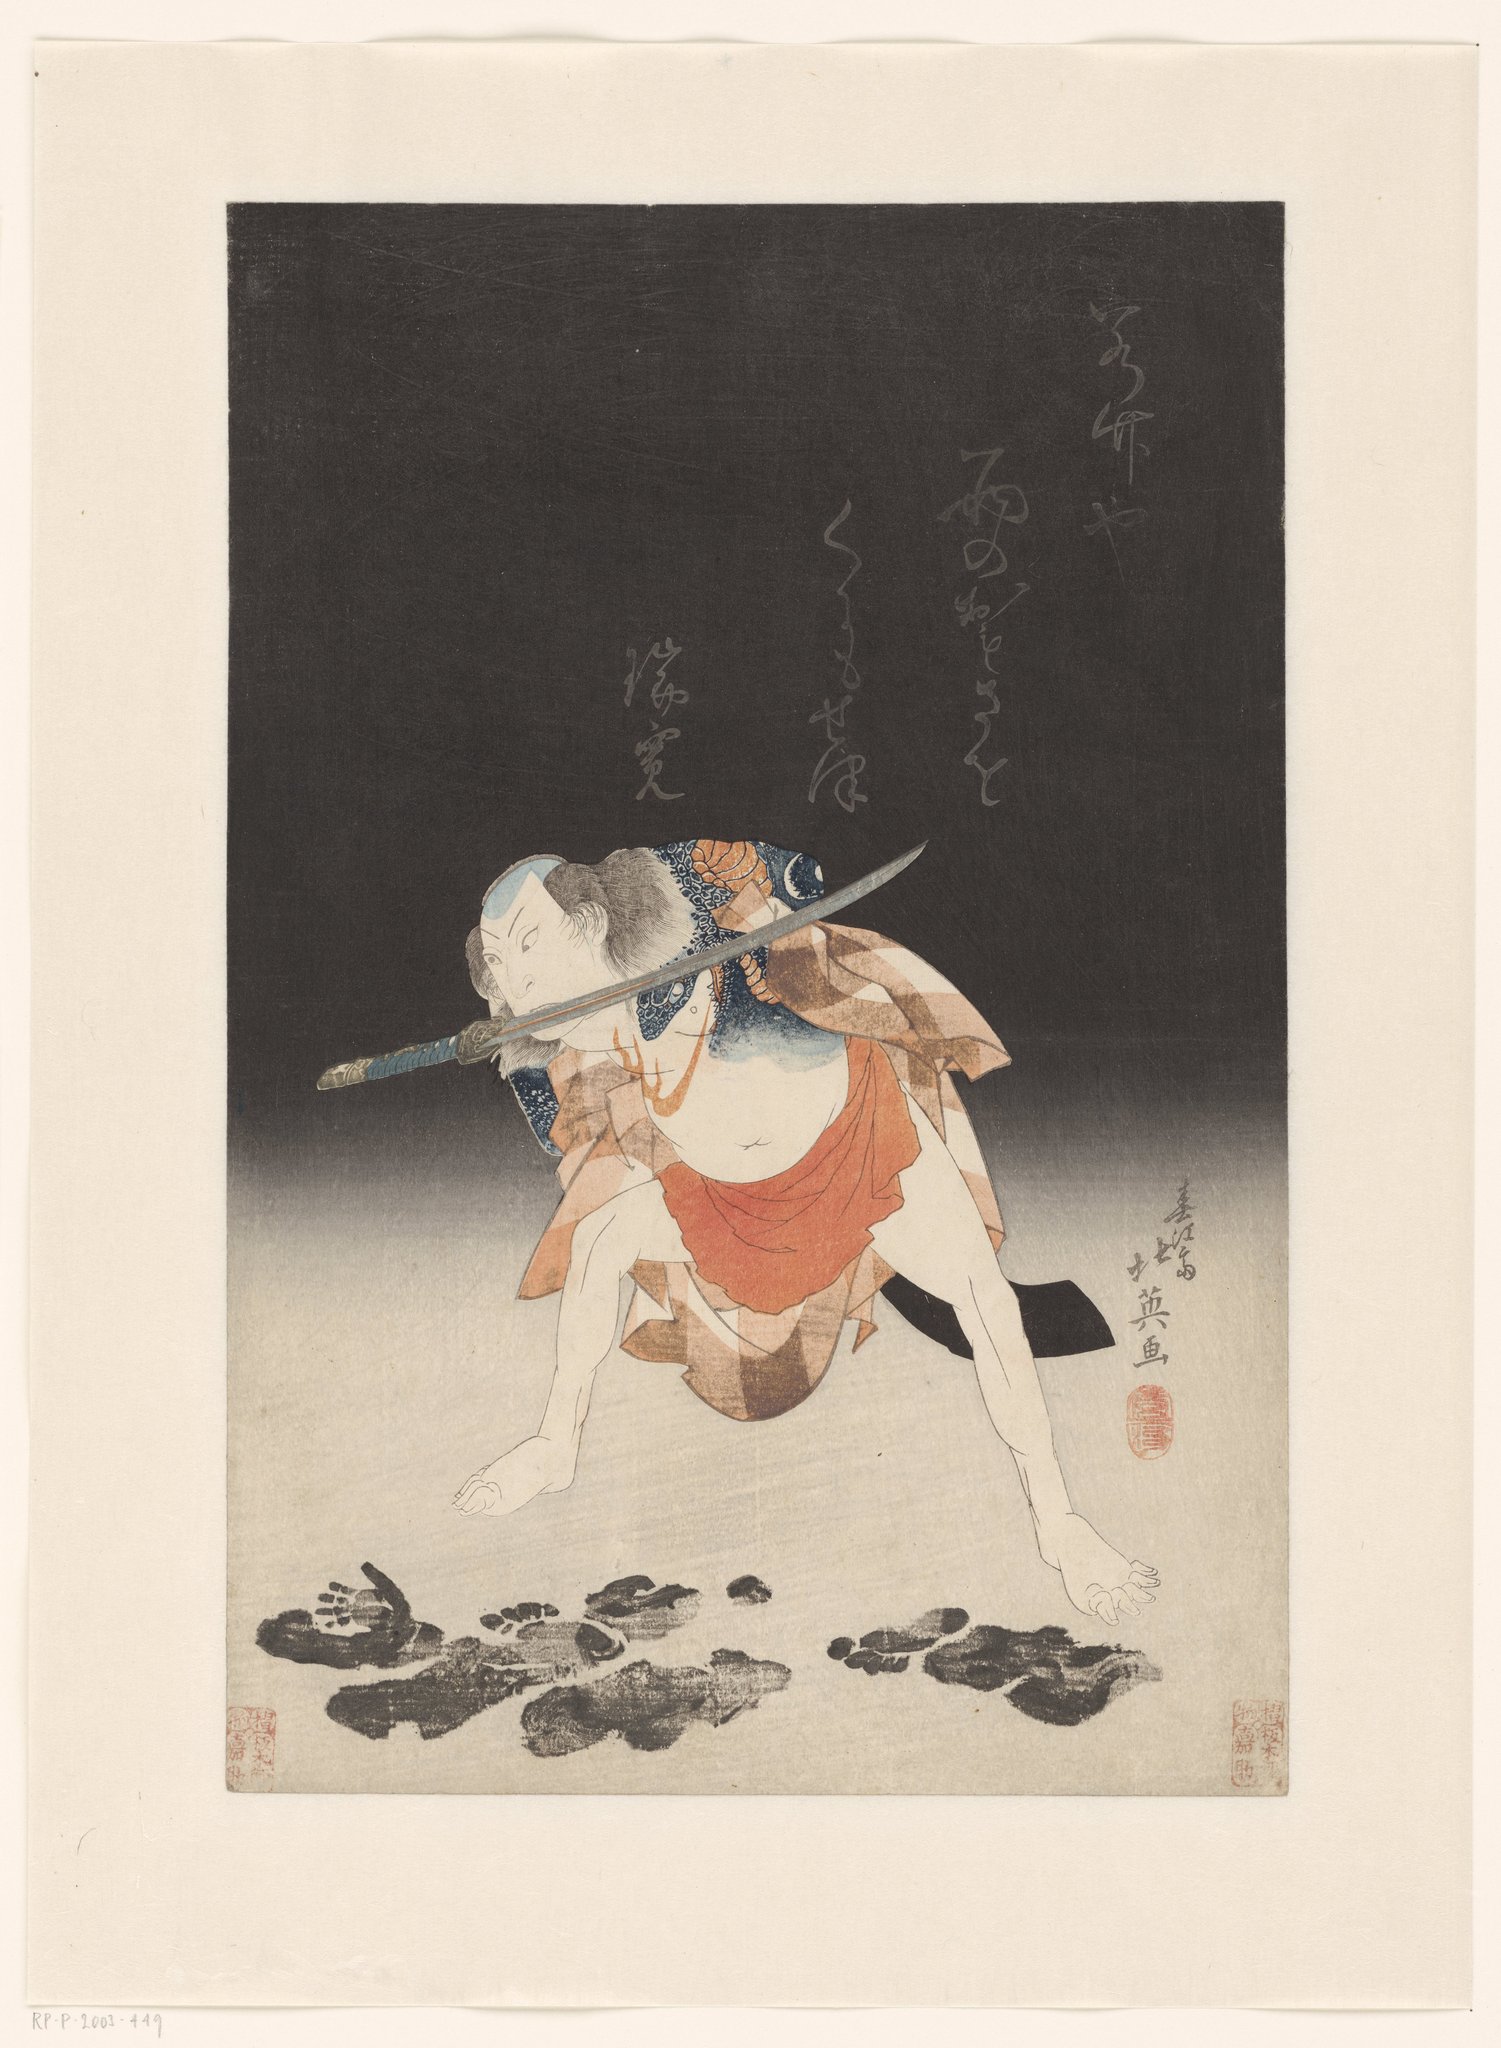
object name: print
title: Arashi Rikan II als Danshichi Kurobei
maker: shunbaisai hokuei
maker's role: print maker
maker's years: -1837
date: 1930-1935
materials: paper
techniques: woodcut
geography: japan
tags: actor (on the stage)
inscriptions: collector's mark: Lugt 2228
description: De acteur Arashi Rikan II als Danshichi Kurobei in het toneelstuk Natsu matsuri (het zomerfestival). De getatoeëerde Danshichi Kurobei, voorover gebogen, een zwaard tussen de tanden, kijkend naar hand- en voetafdrukken op de grond.